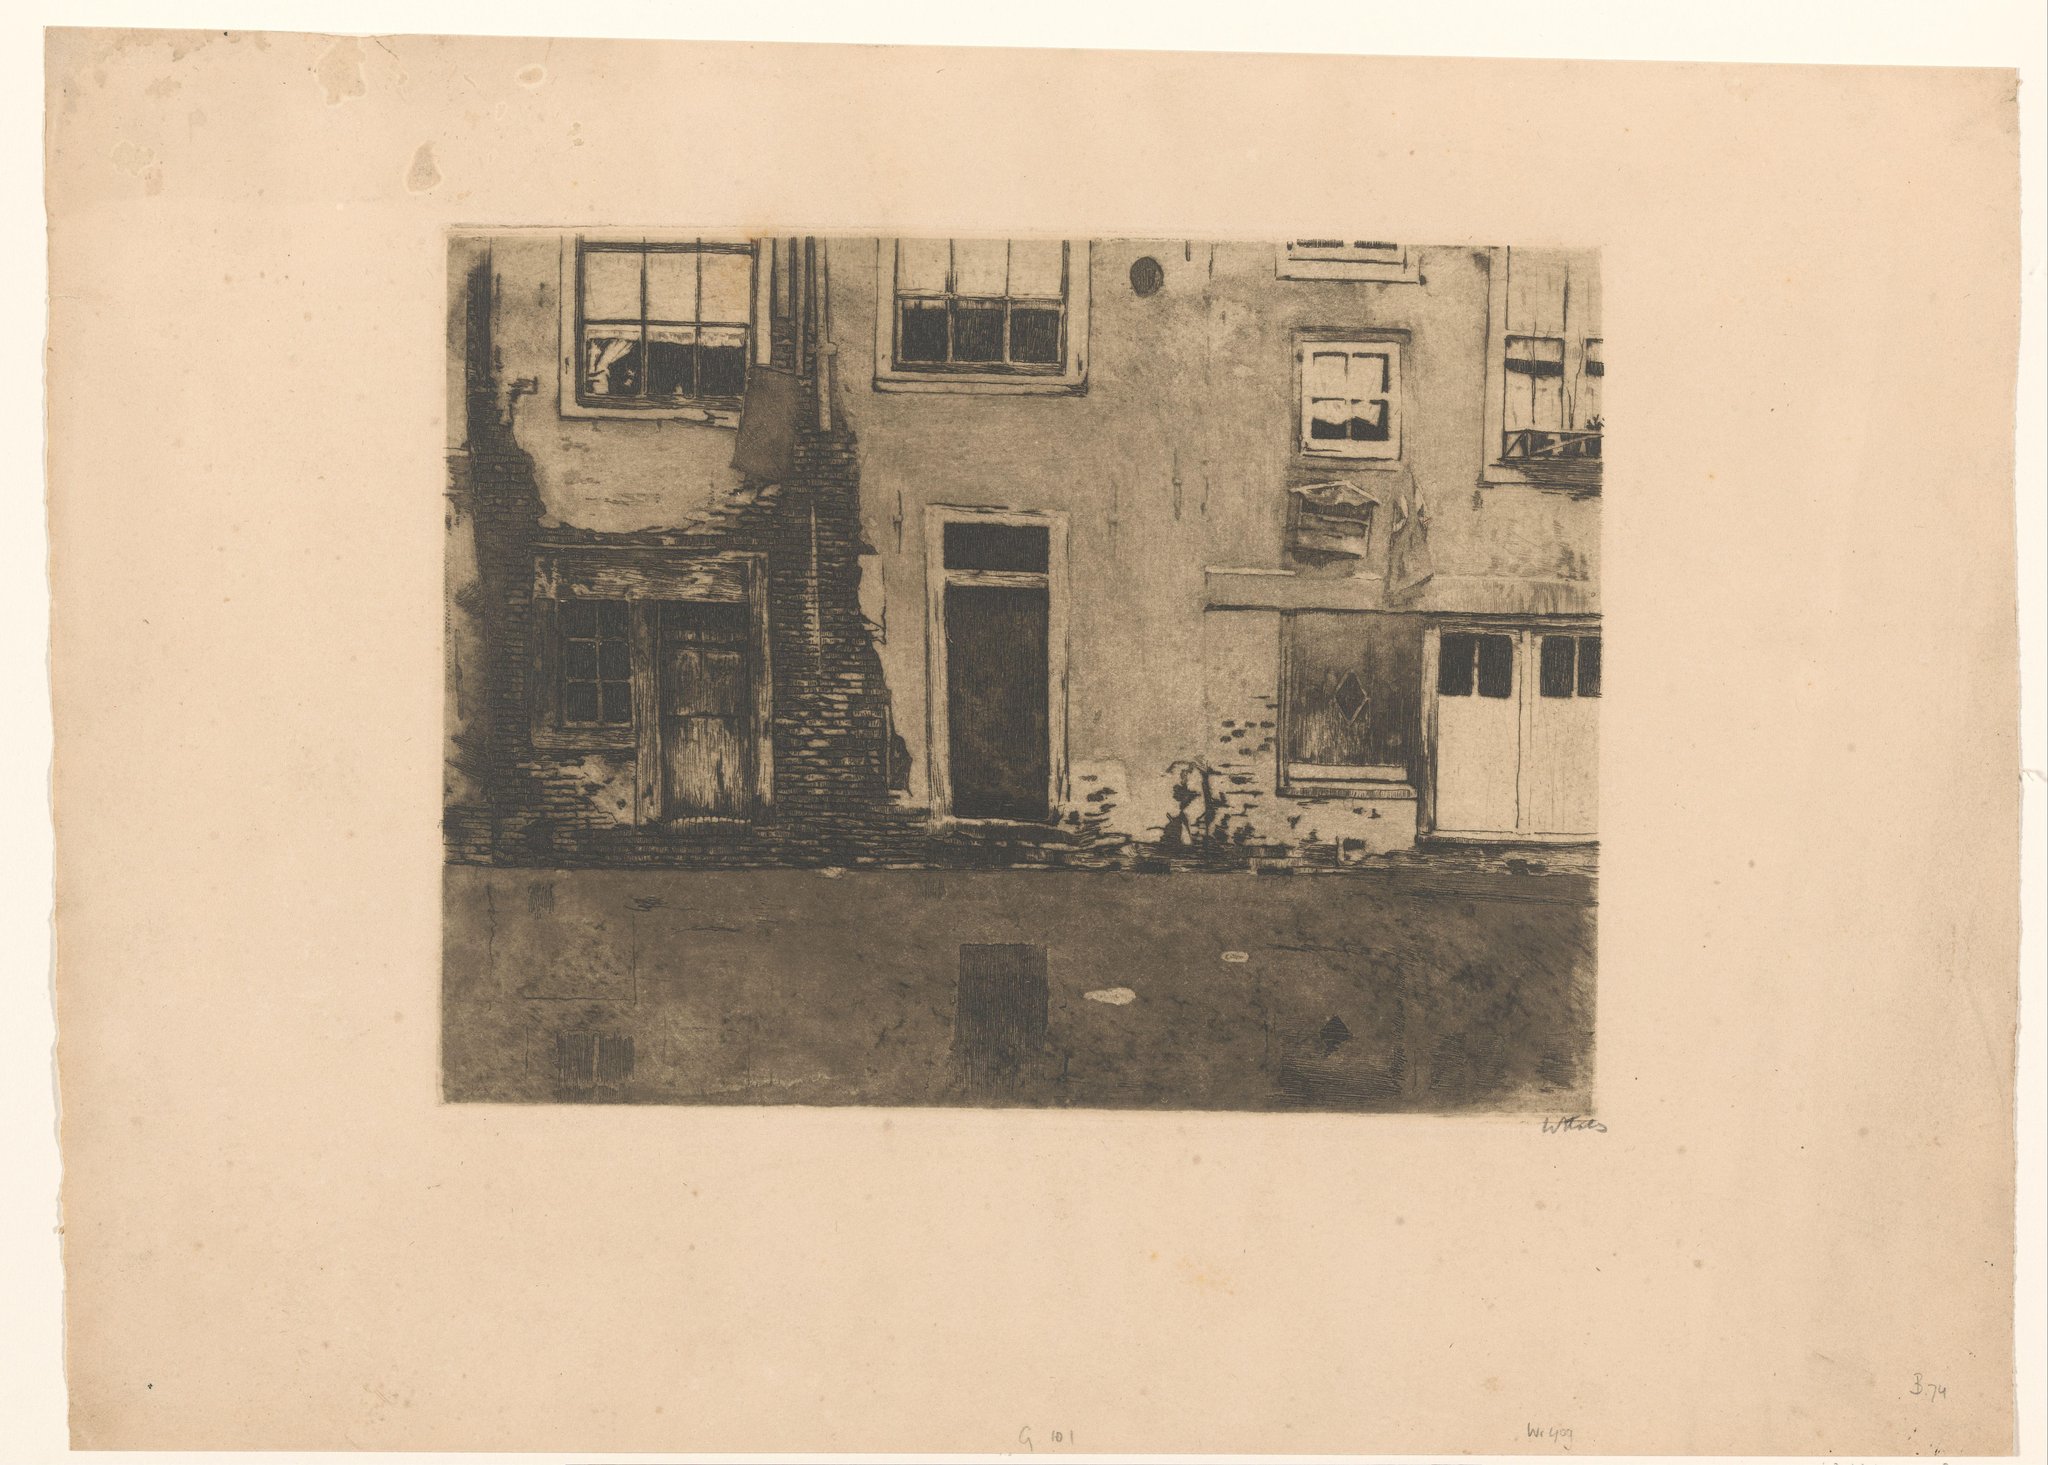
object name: print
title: Gezicht op de achterzijde van de Zeedijk in Amsterdam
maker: willem witsen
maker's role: draughtsman, painter, print maker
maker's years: 1860-1923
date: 1897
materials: paper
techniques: aquatint, etching, intaglio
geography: amsterdam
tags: urban housing, window, canals, waters (in city)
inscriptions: collector's mark: Lugt 2228, signature: ‘Witsen’, watermark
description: Gezicht op de achterzijde van de huizen aan de Zeedijk, tussen de Spooksteeg en de Korte Niezel. Gezien vanaf de Oudezijds Achterburgwal.